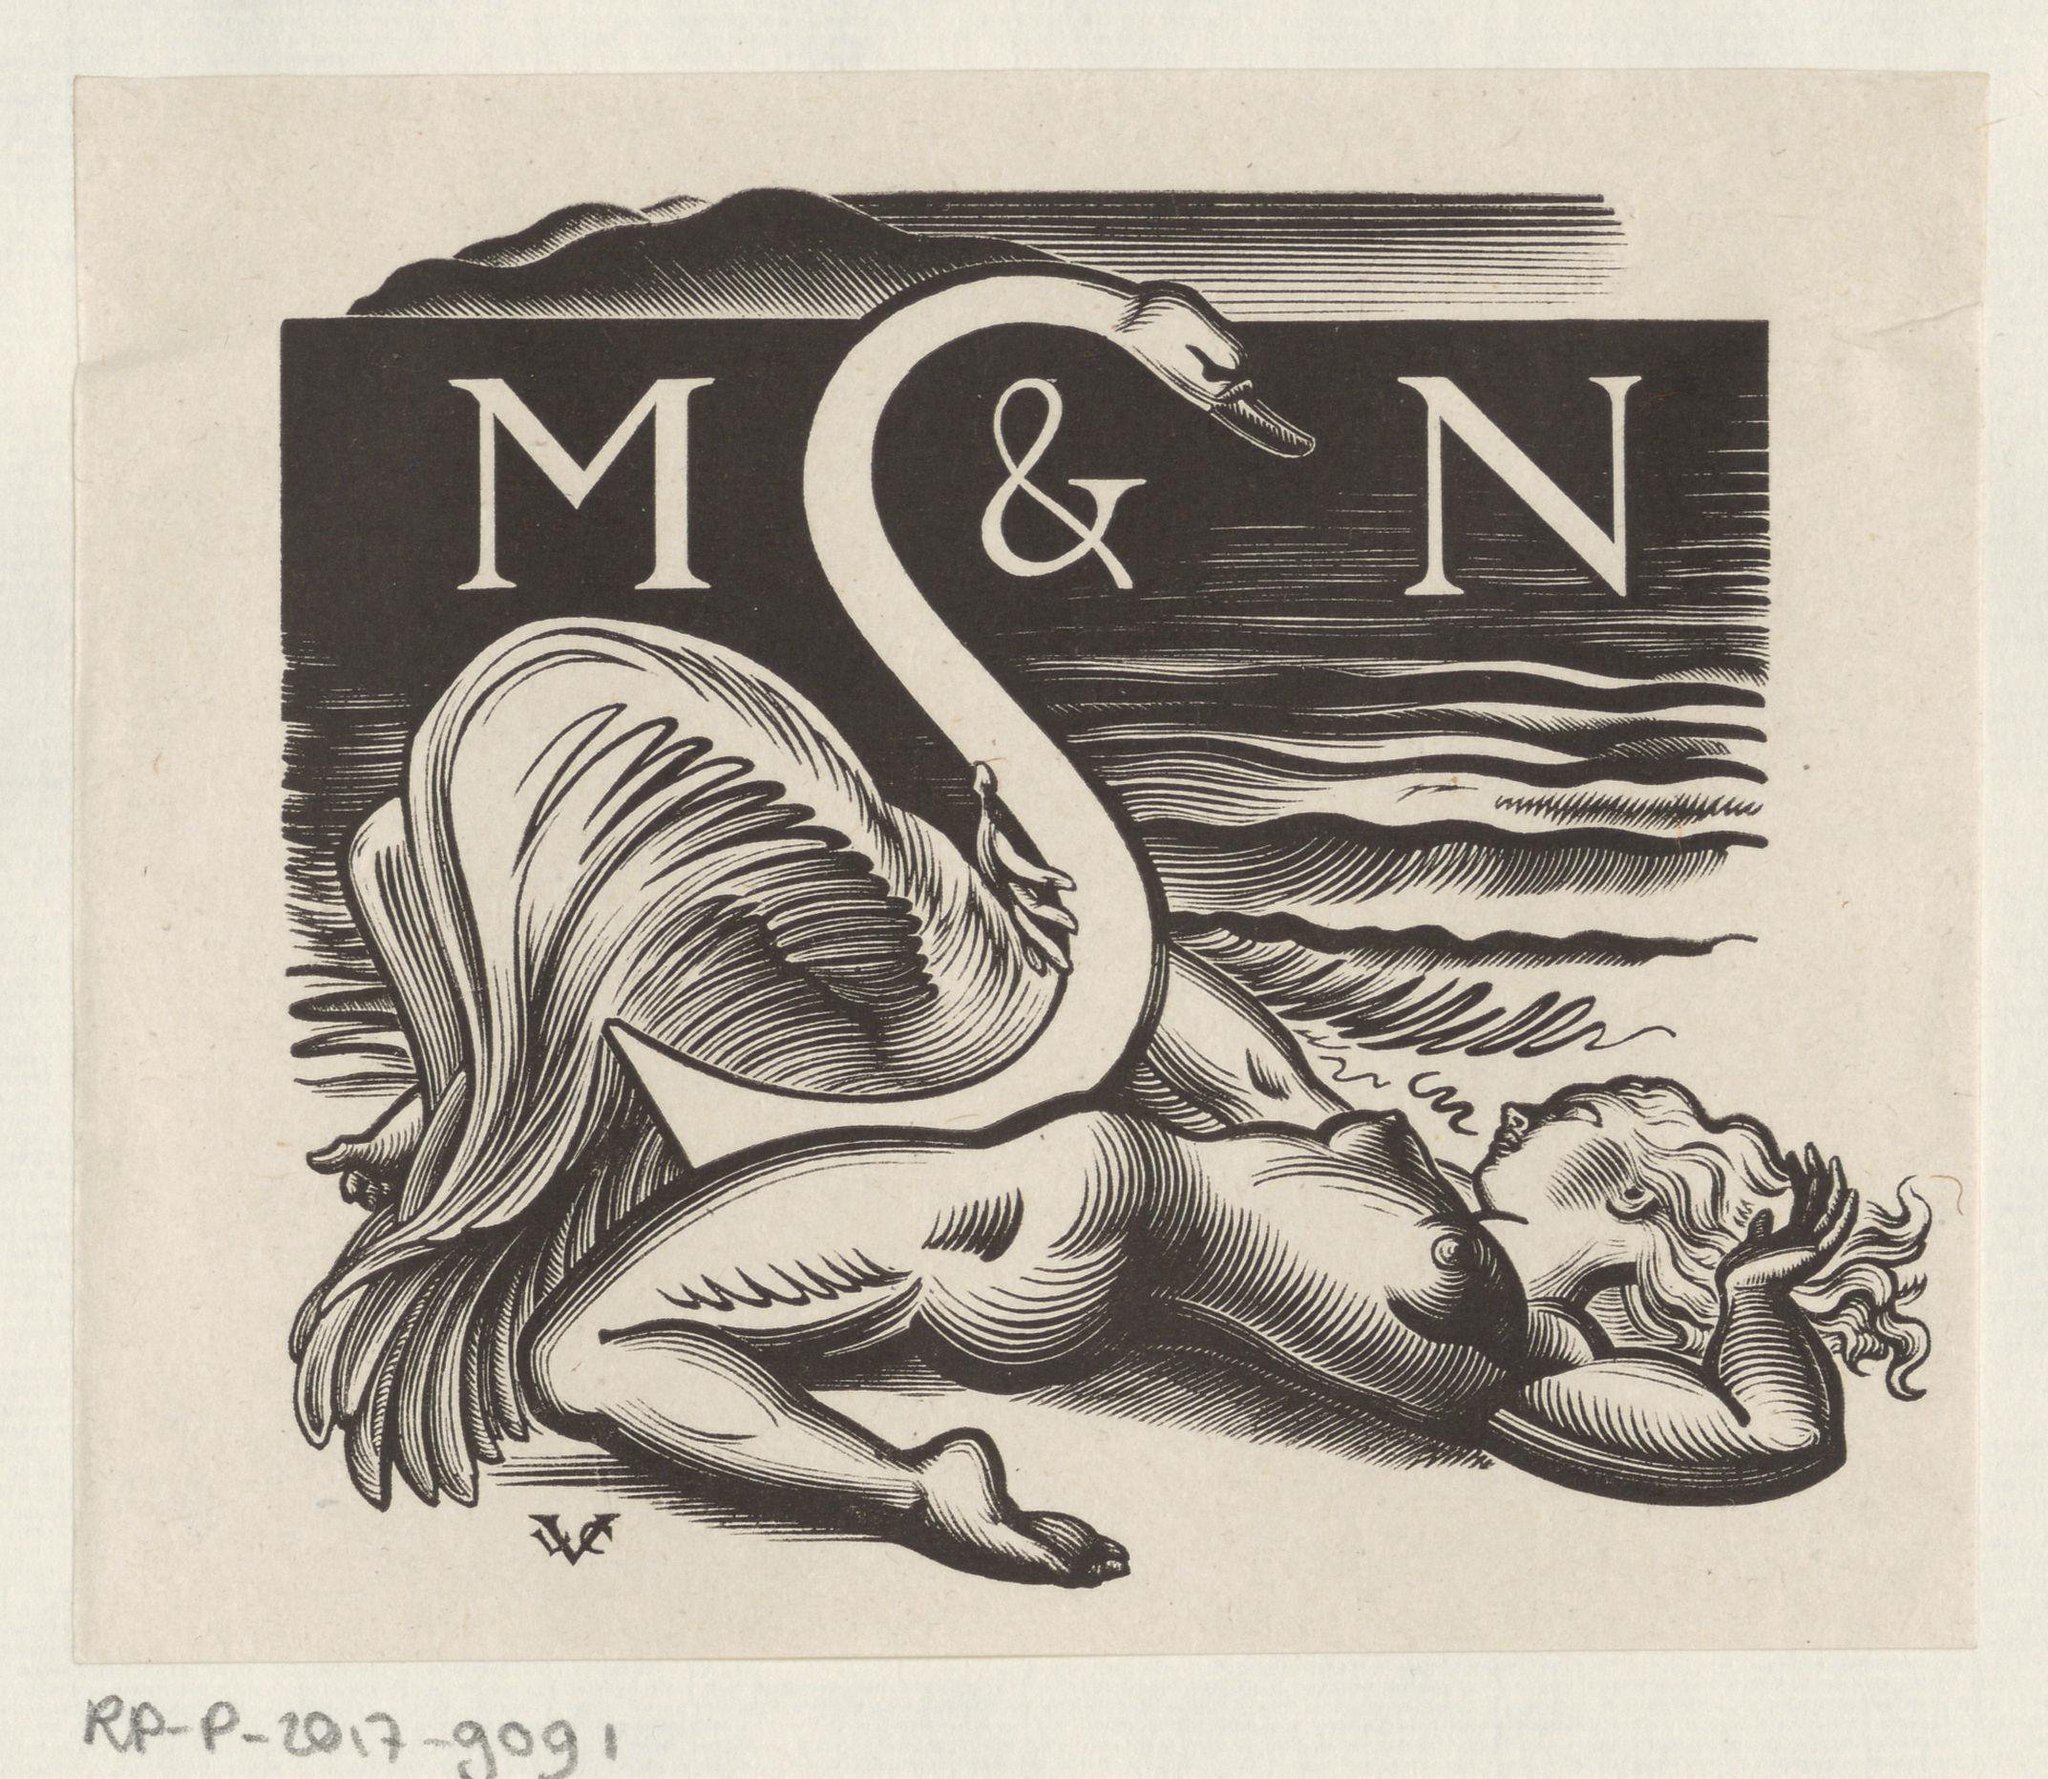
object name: bookplate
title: Ex libris van M. en N. S.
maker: valentin le campion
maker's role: print maker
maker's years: 1861-1952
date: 1920-1952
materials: paper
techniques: engraving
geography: france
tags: jupiter, in the shape of a swan, and leda, woman (showing herself) undressed, quasi-nude, beach